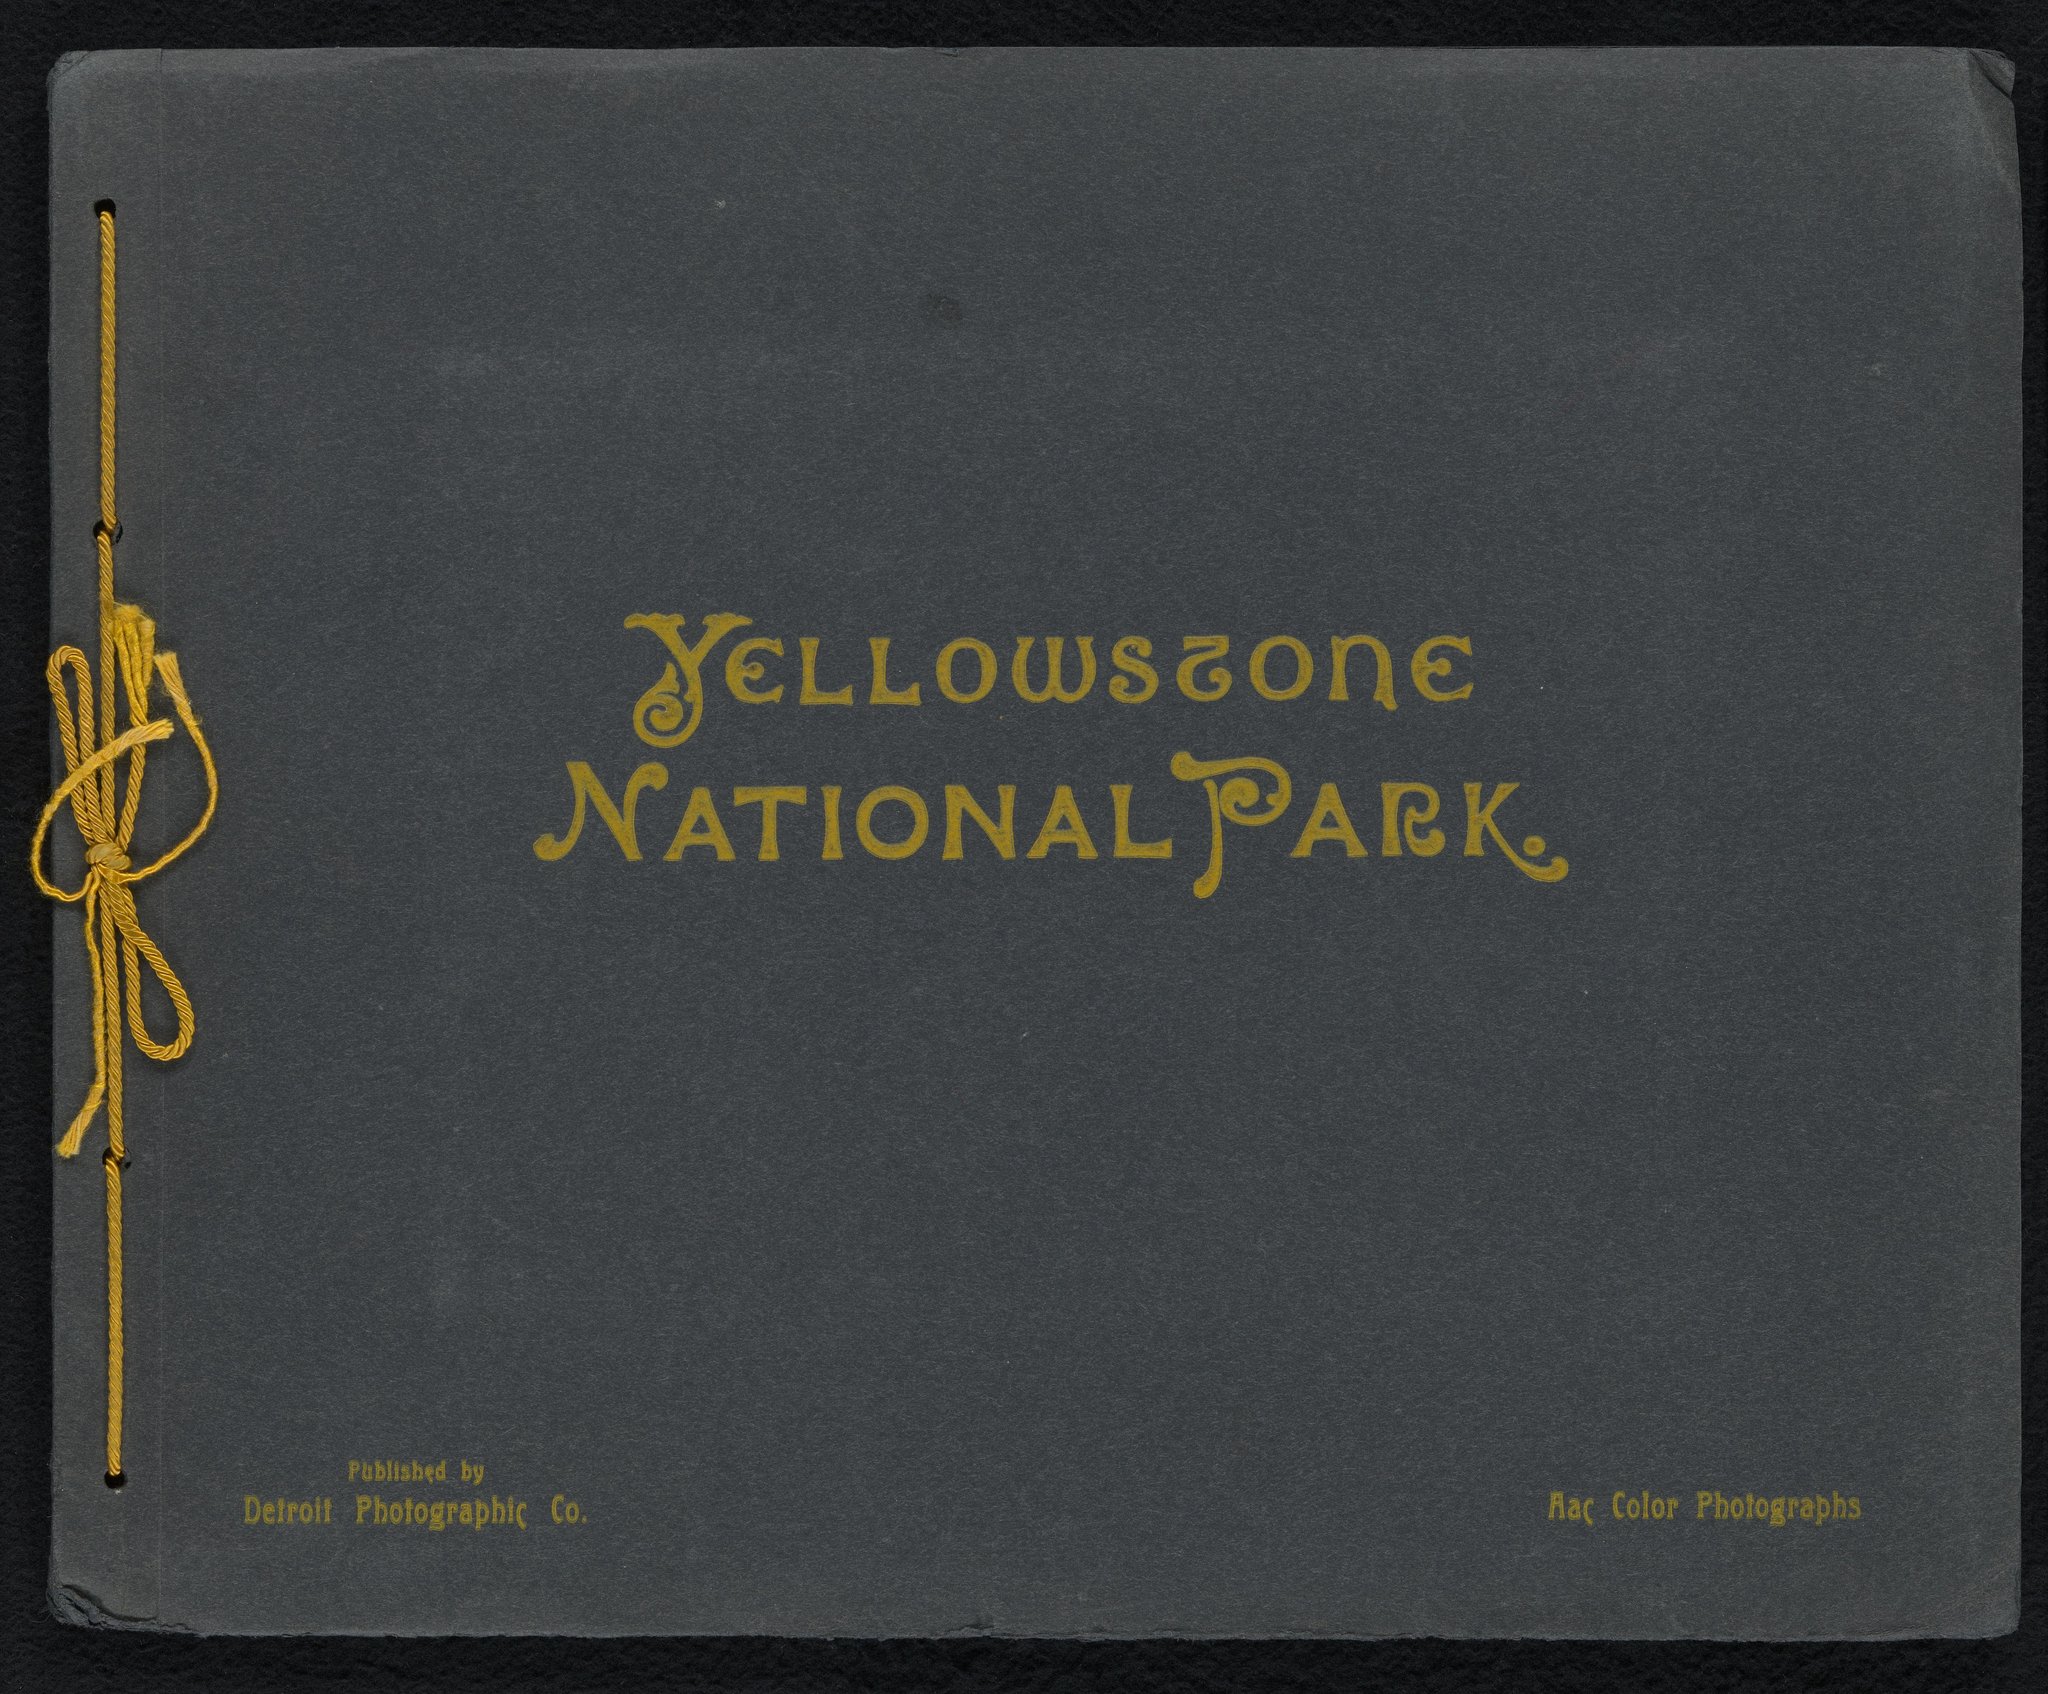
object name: book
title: Yellowstone National Park : Aac color photographs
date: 1902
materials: paper, photographic process, fiber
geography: detroit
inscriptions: number: ‘F 376/E/4’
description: Album met 20 prenten van Yellowstone National Park.